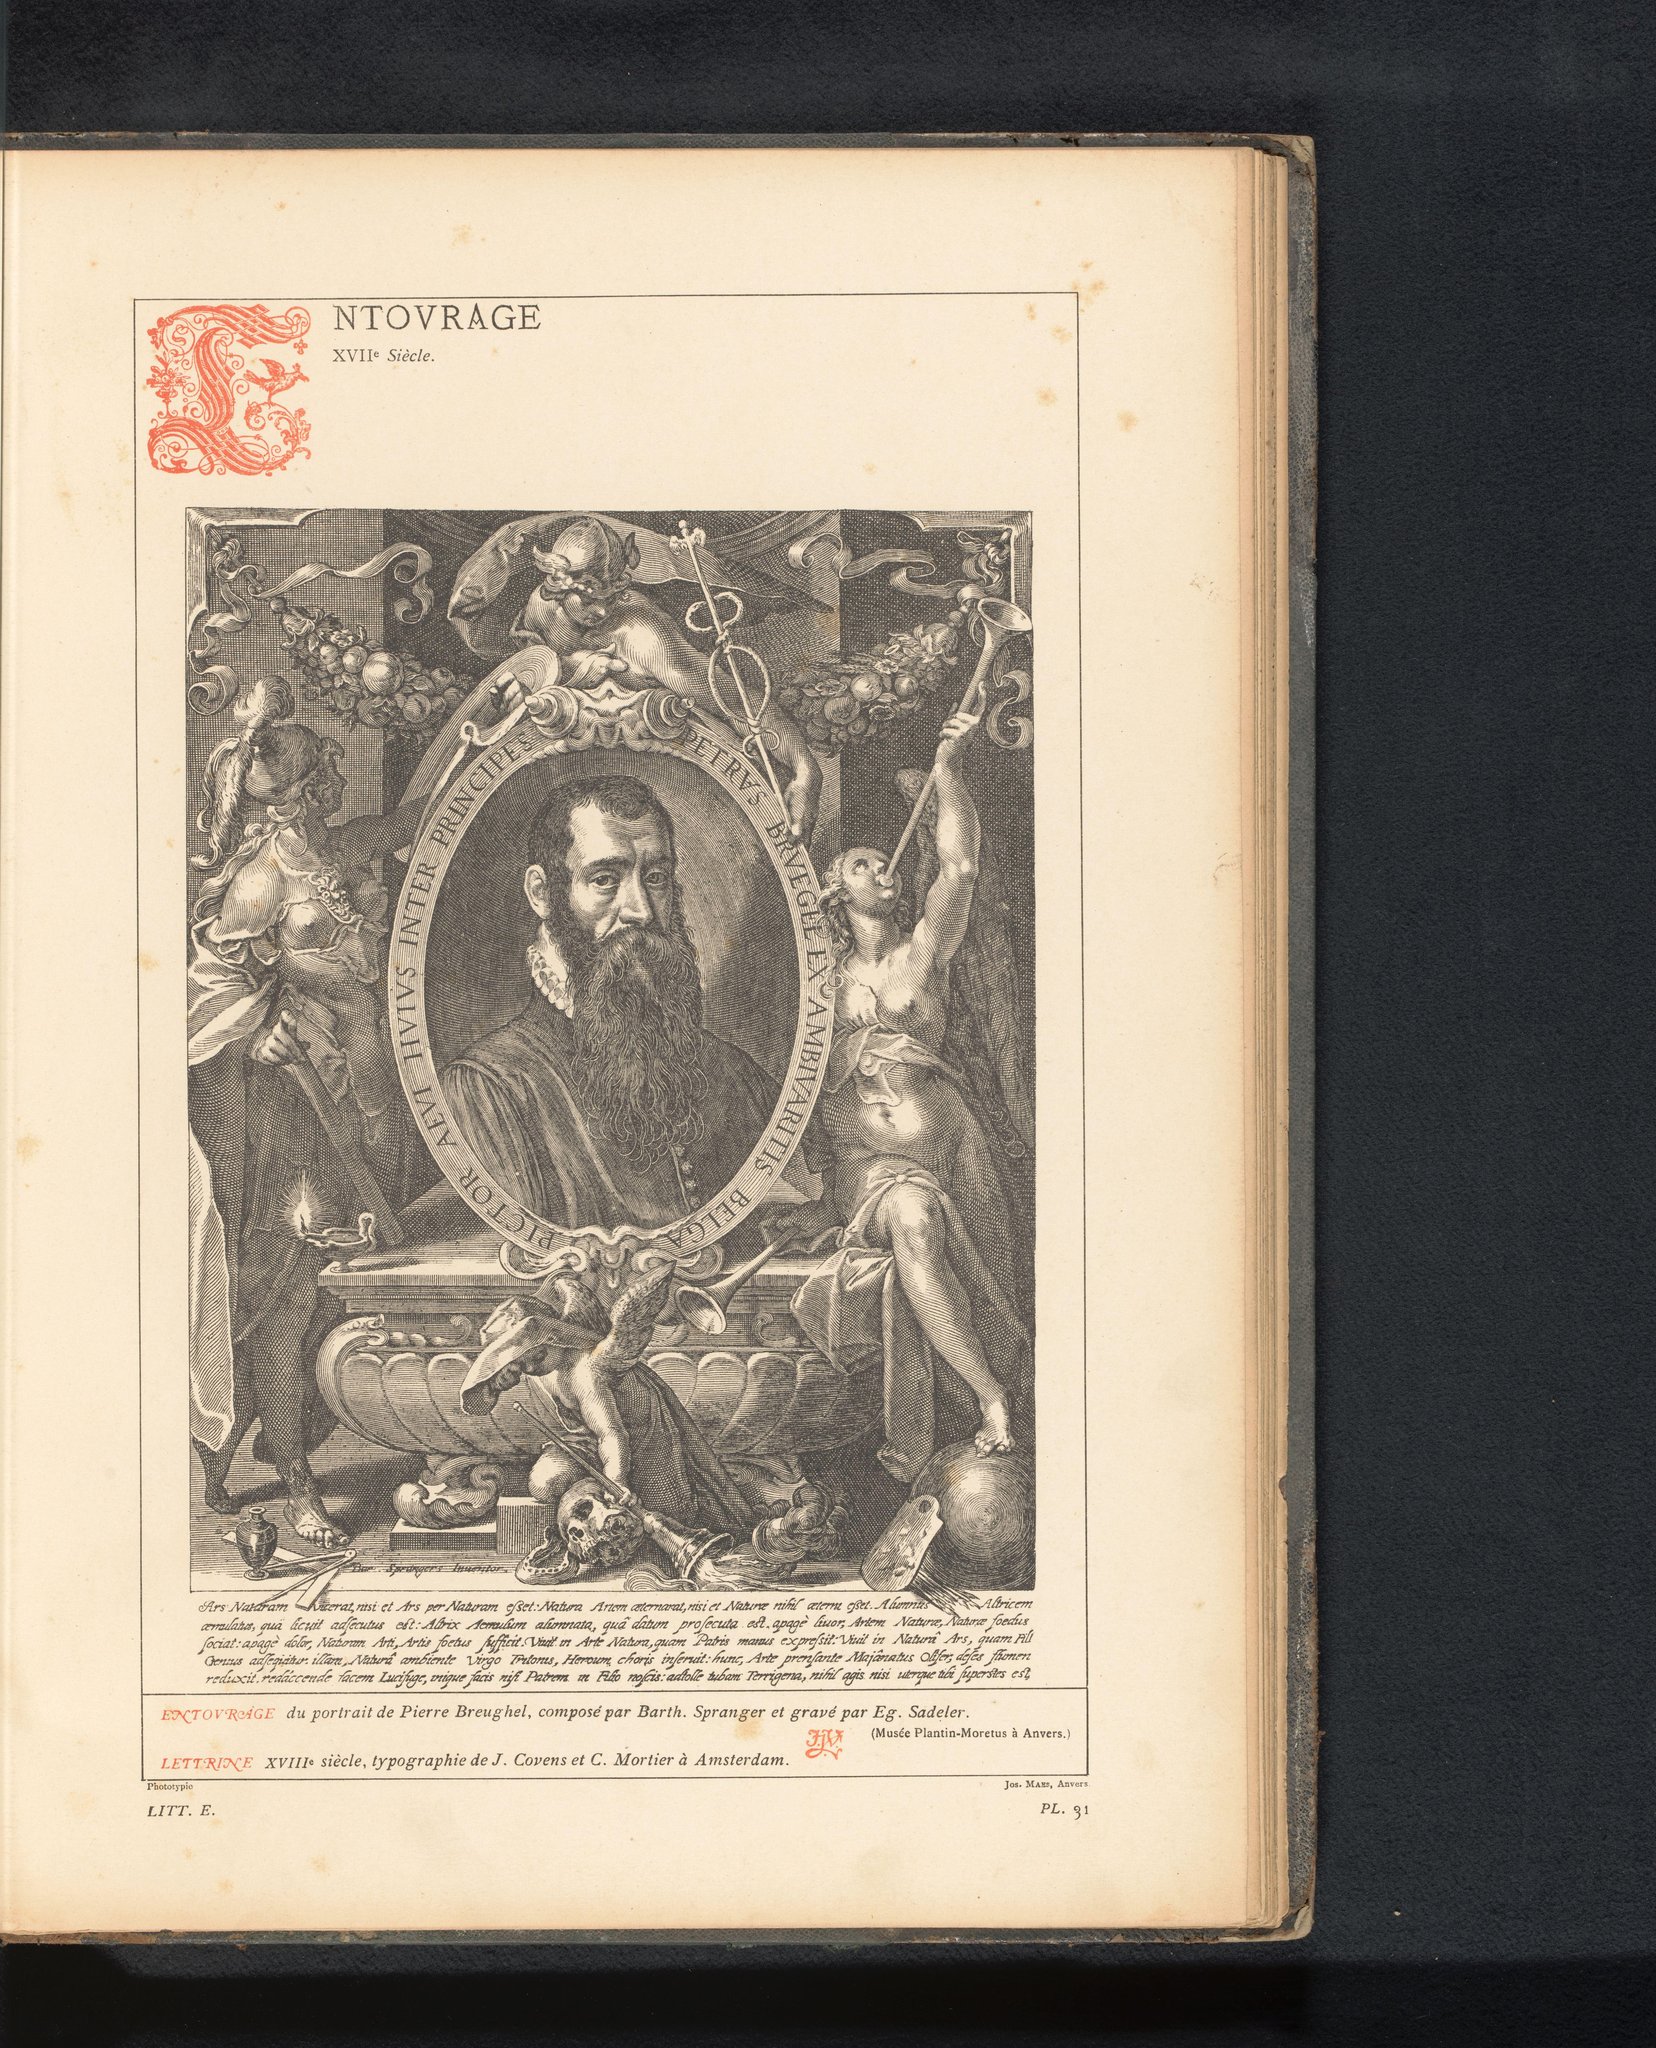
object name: photomechanical print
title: Reproductie van een prent van een portret van Pieter Brueghel door Aegidius Sadeler naar Bartholomeus Spranger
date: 1875-1880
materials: paper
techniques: photolithography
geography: amsterdam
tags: pieter brueghel, historical persons, portrait, self-portrait of painter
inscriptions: monogram: ‘JJvY’, inscription: ‘ENTOURAGE du portrait (...)’, inscription: ‘LITT. E. - PL. 31’